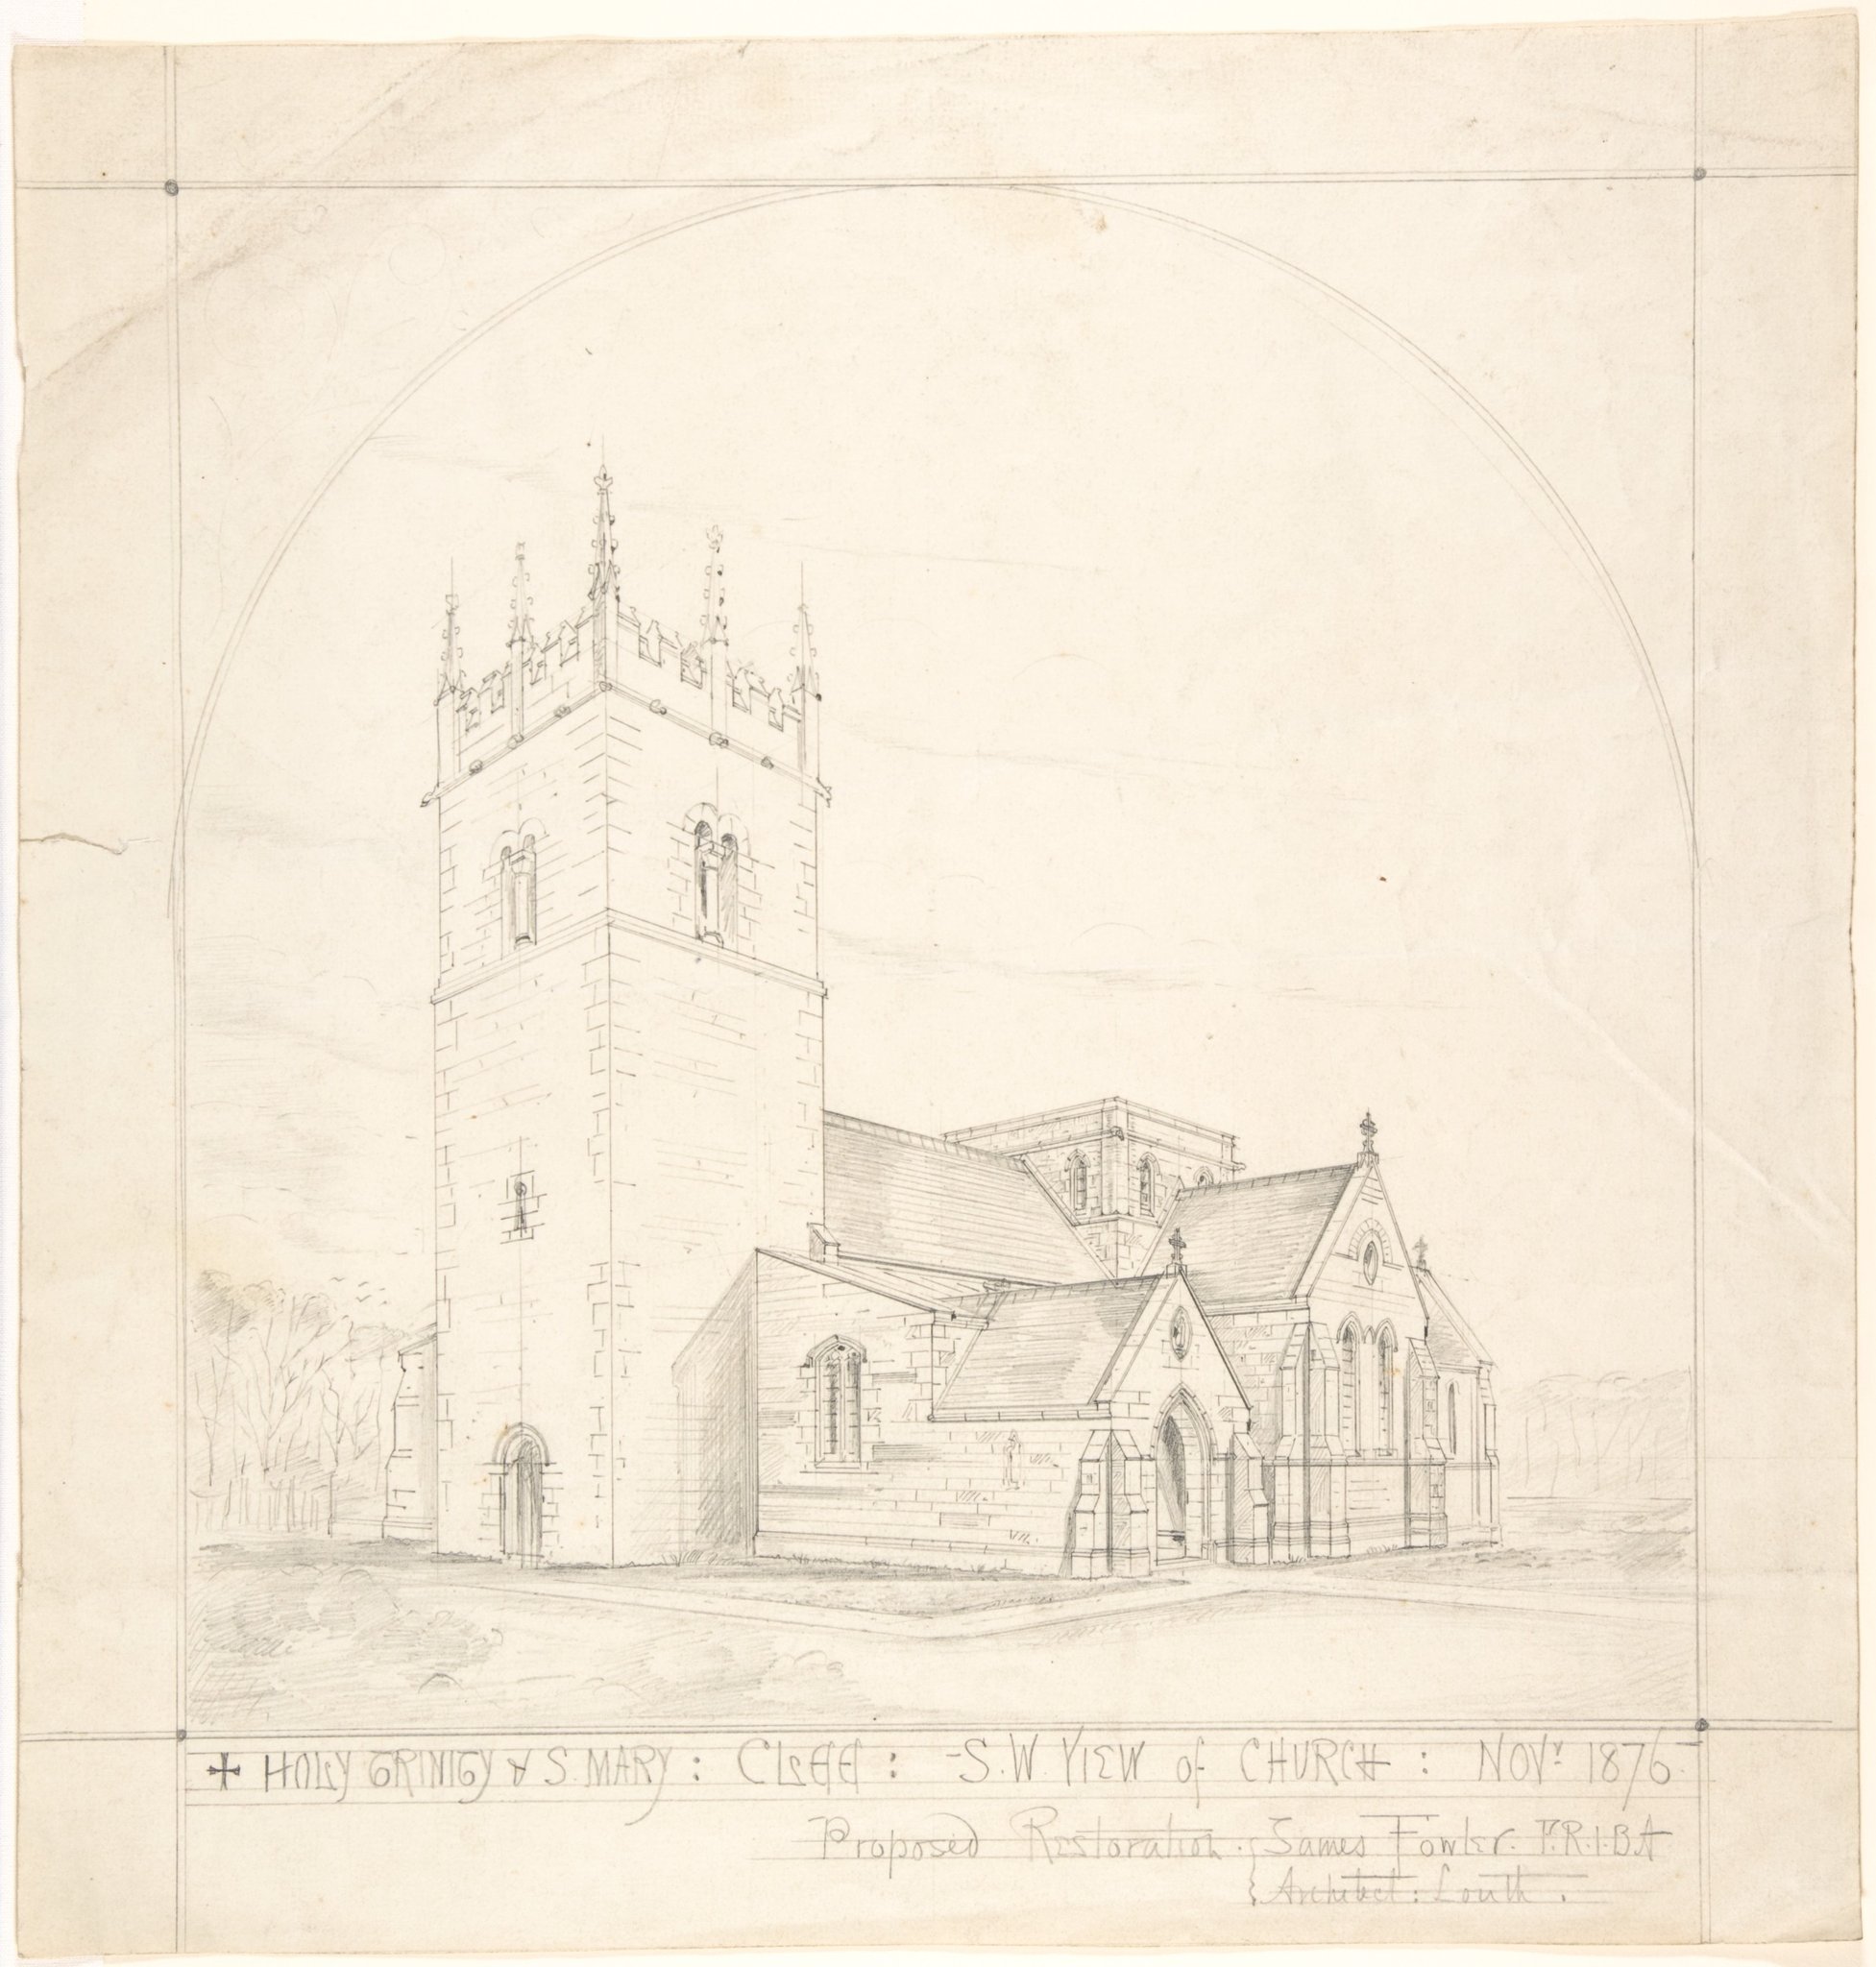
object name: drawing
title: Proposed Restoration of the Church of the Holy Trinity and St. Mary, Old Clee, Lincolnshire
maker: james fowler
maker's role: artist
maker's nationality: british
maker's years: 1828-1892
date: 1876-1877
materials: graphite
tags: churches